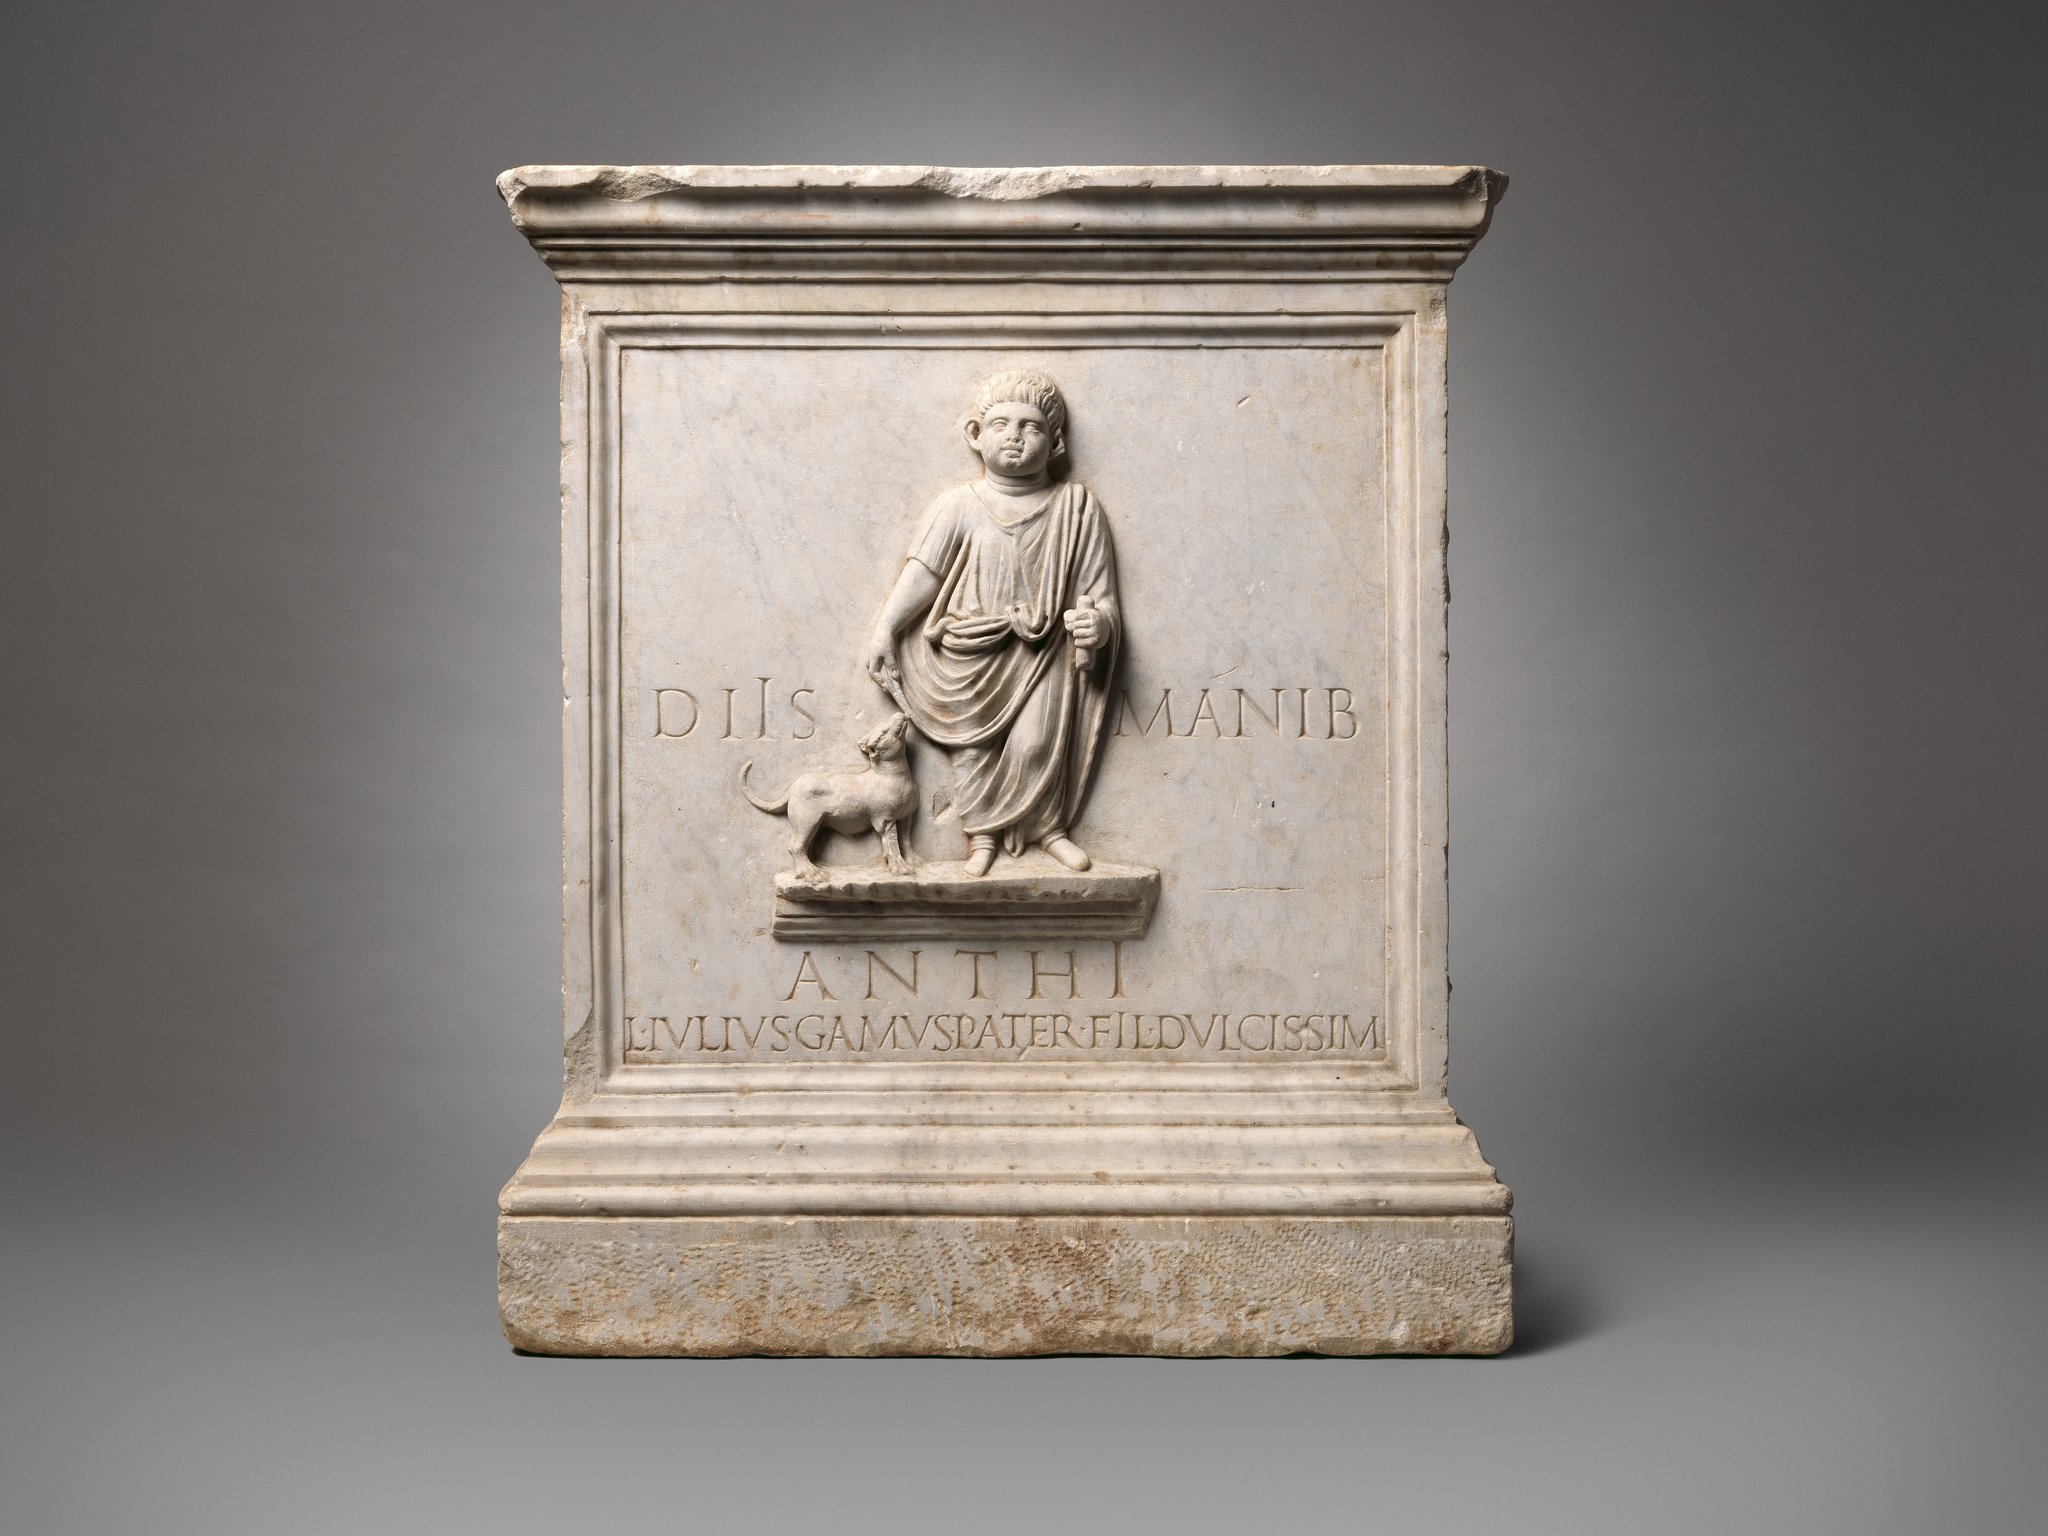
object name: funerary altar of anthus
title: Marble funerary altar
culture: roman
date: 1-50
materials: marble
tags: birds,boys,dogs,snakes,trees